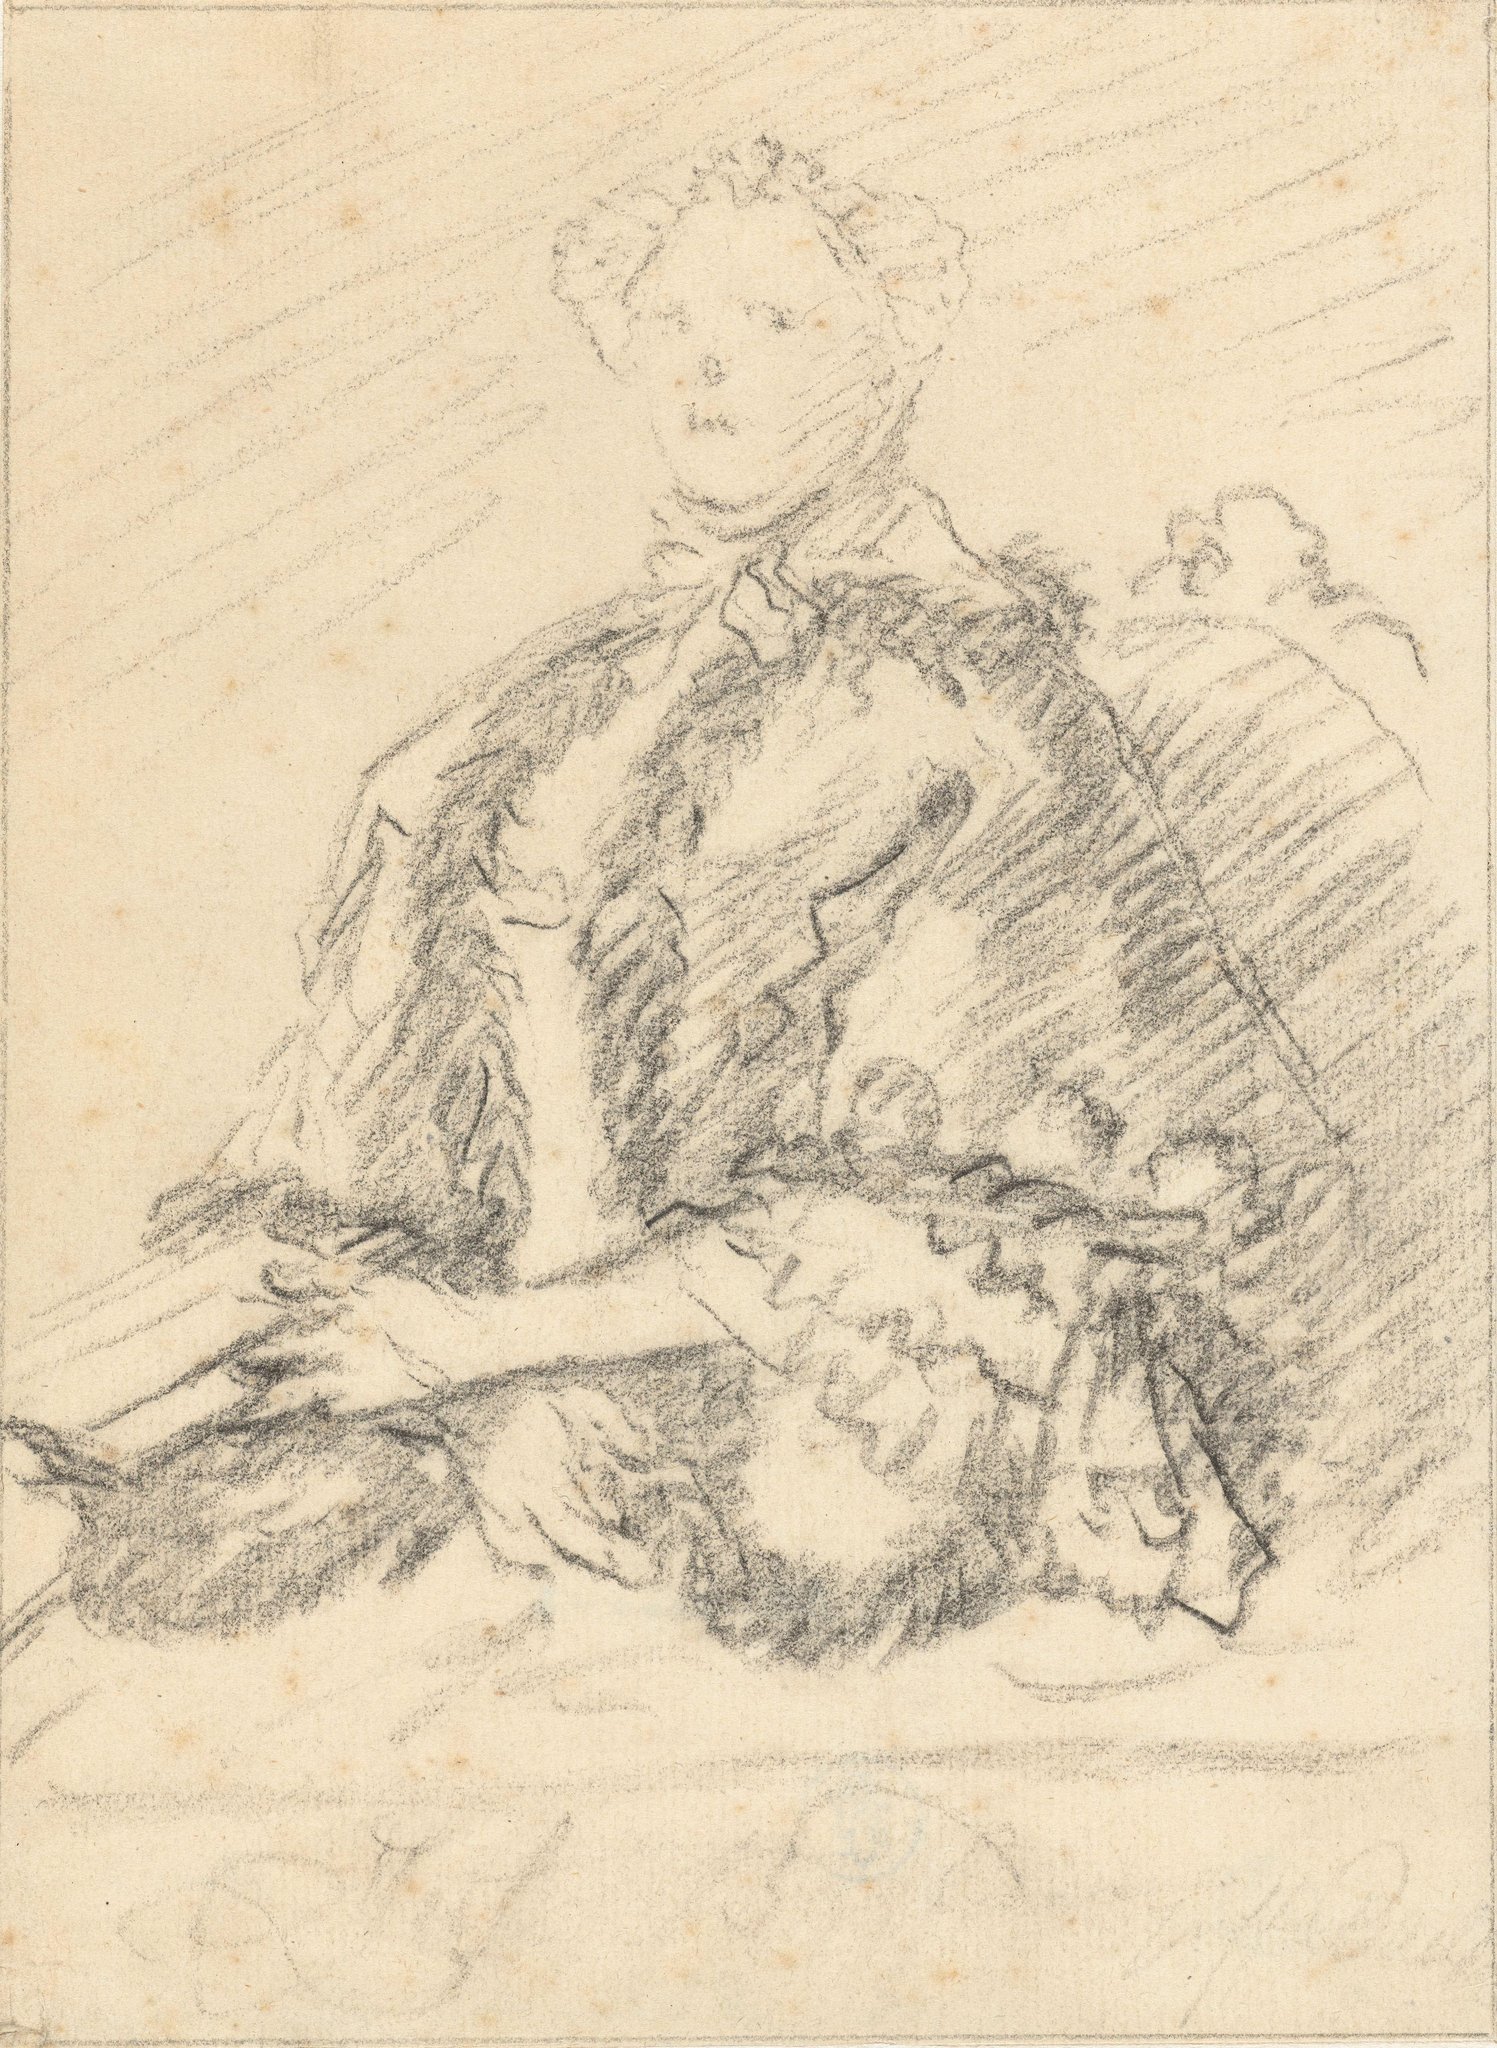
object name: drawing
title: Portret van 'Juf Baelde', mogelijk Maria Bisdom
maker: dionys van nijmegen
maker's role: draughtsman, painter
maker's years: 1705-1798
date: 1725-1770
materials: chalk, graphite, paper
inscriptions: signature: ‘door Dr Dion van Nijmegen’, inscription: ‘Juf Baelde’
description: De tekening is de voorstudie voor een niet bekend geschilderd portret van Maria Bisdom (1712-1770), de echtgenote van Rudolf Baelde (1703-1772).